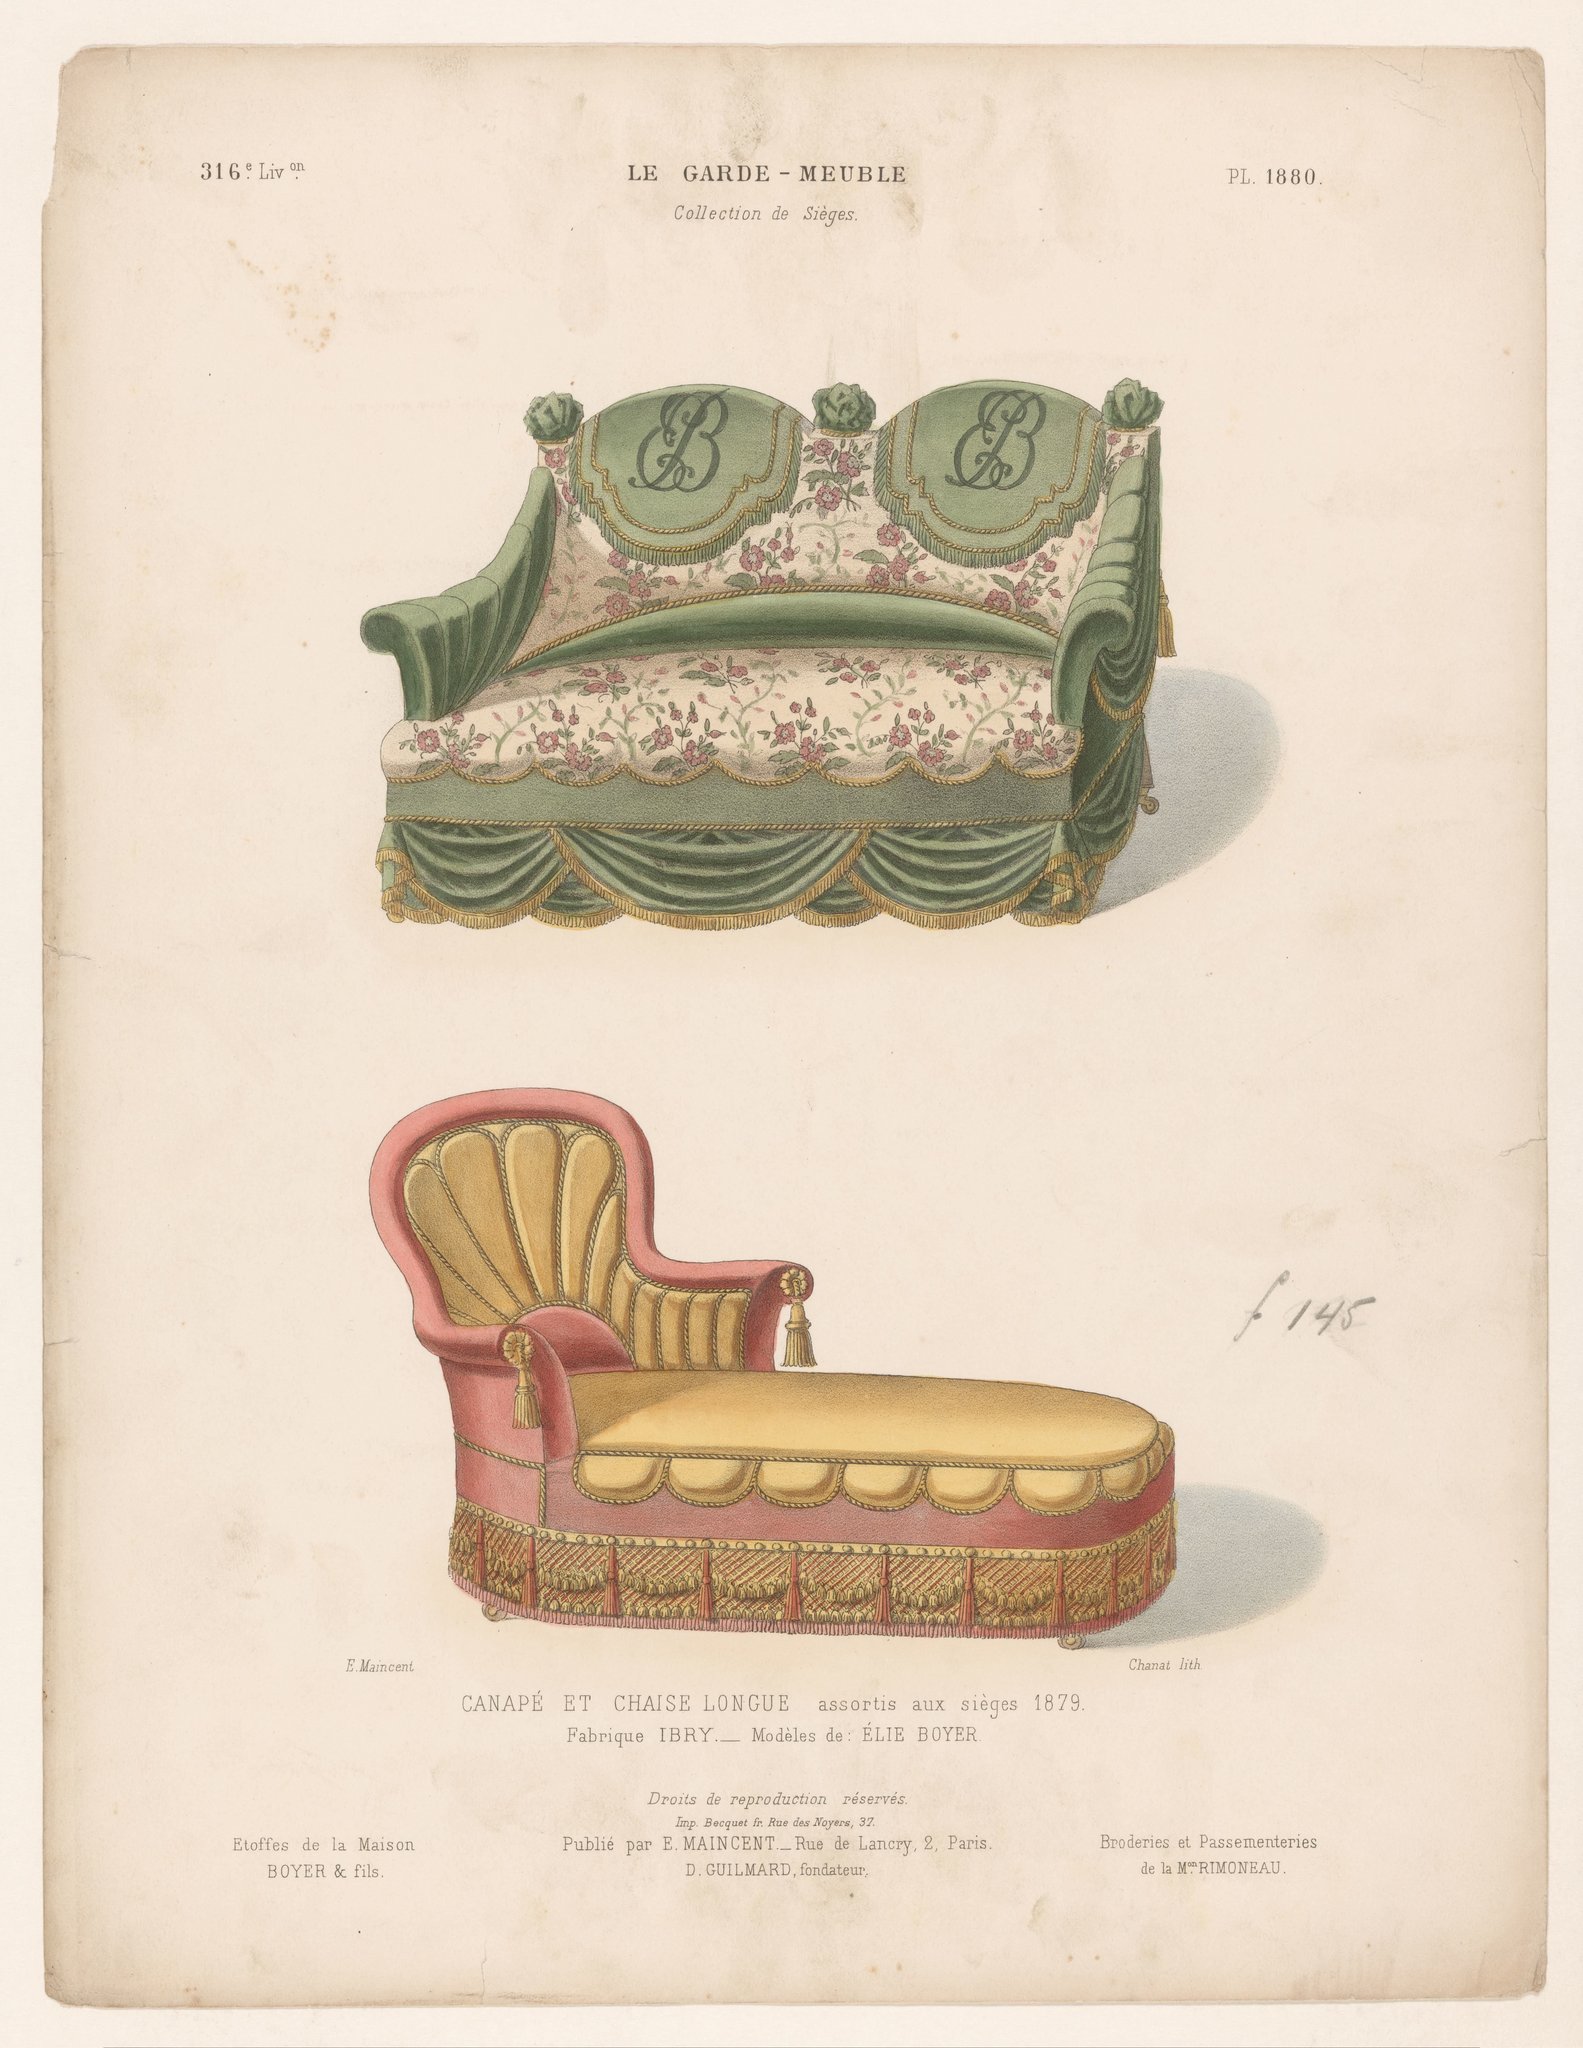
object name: print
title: Canapé et chaise longue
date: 1885-1895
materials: paper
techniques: hand coloring, lithograph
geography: paris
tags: seating furniture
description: Ieder Livraison in de serie Le Garde-Meuble bevat negen platen: drie 'sièges' (zitmeubels), drie 'meubles' (diverse meubels zoals tafels en kasten) en drie 'tentures' (gordijnen en draperieën).